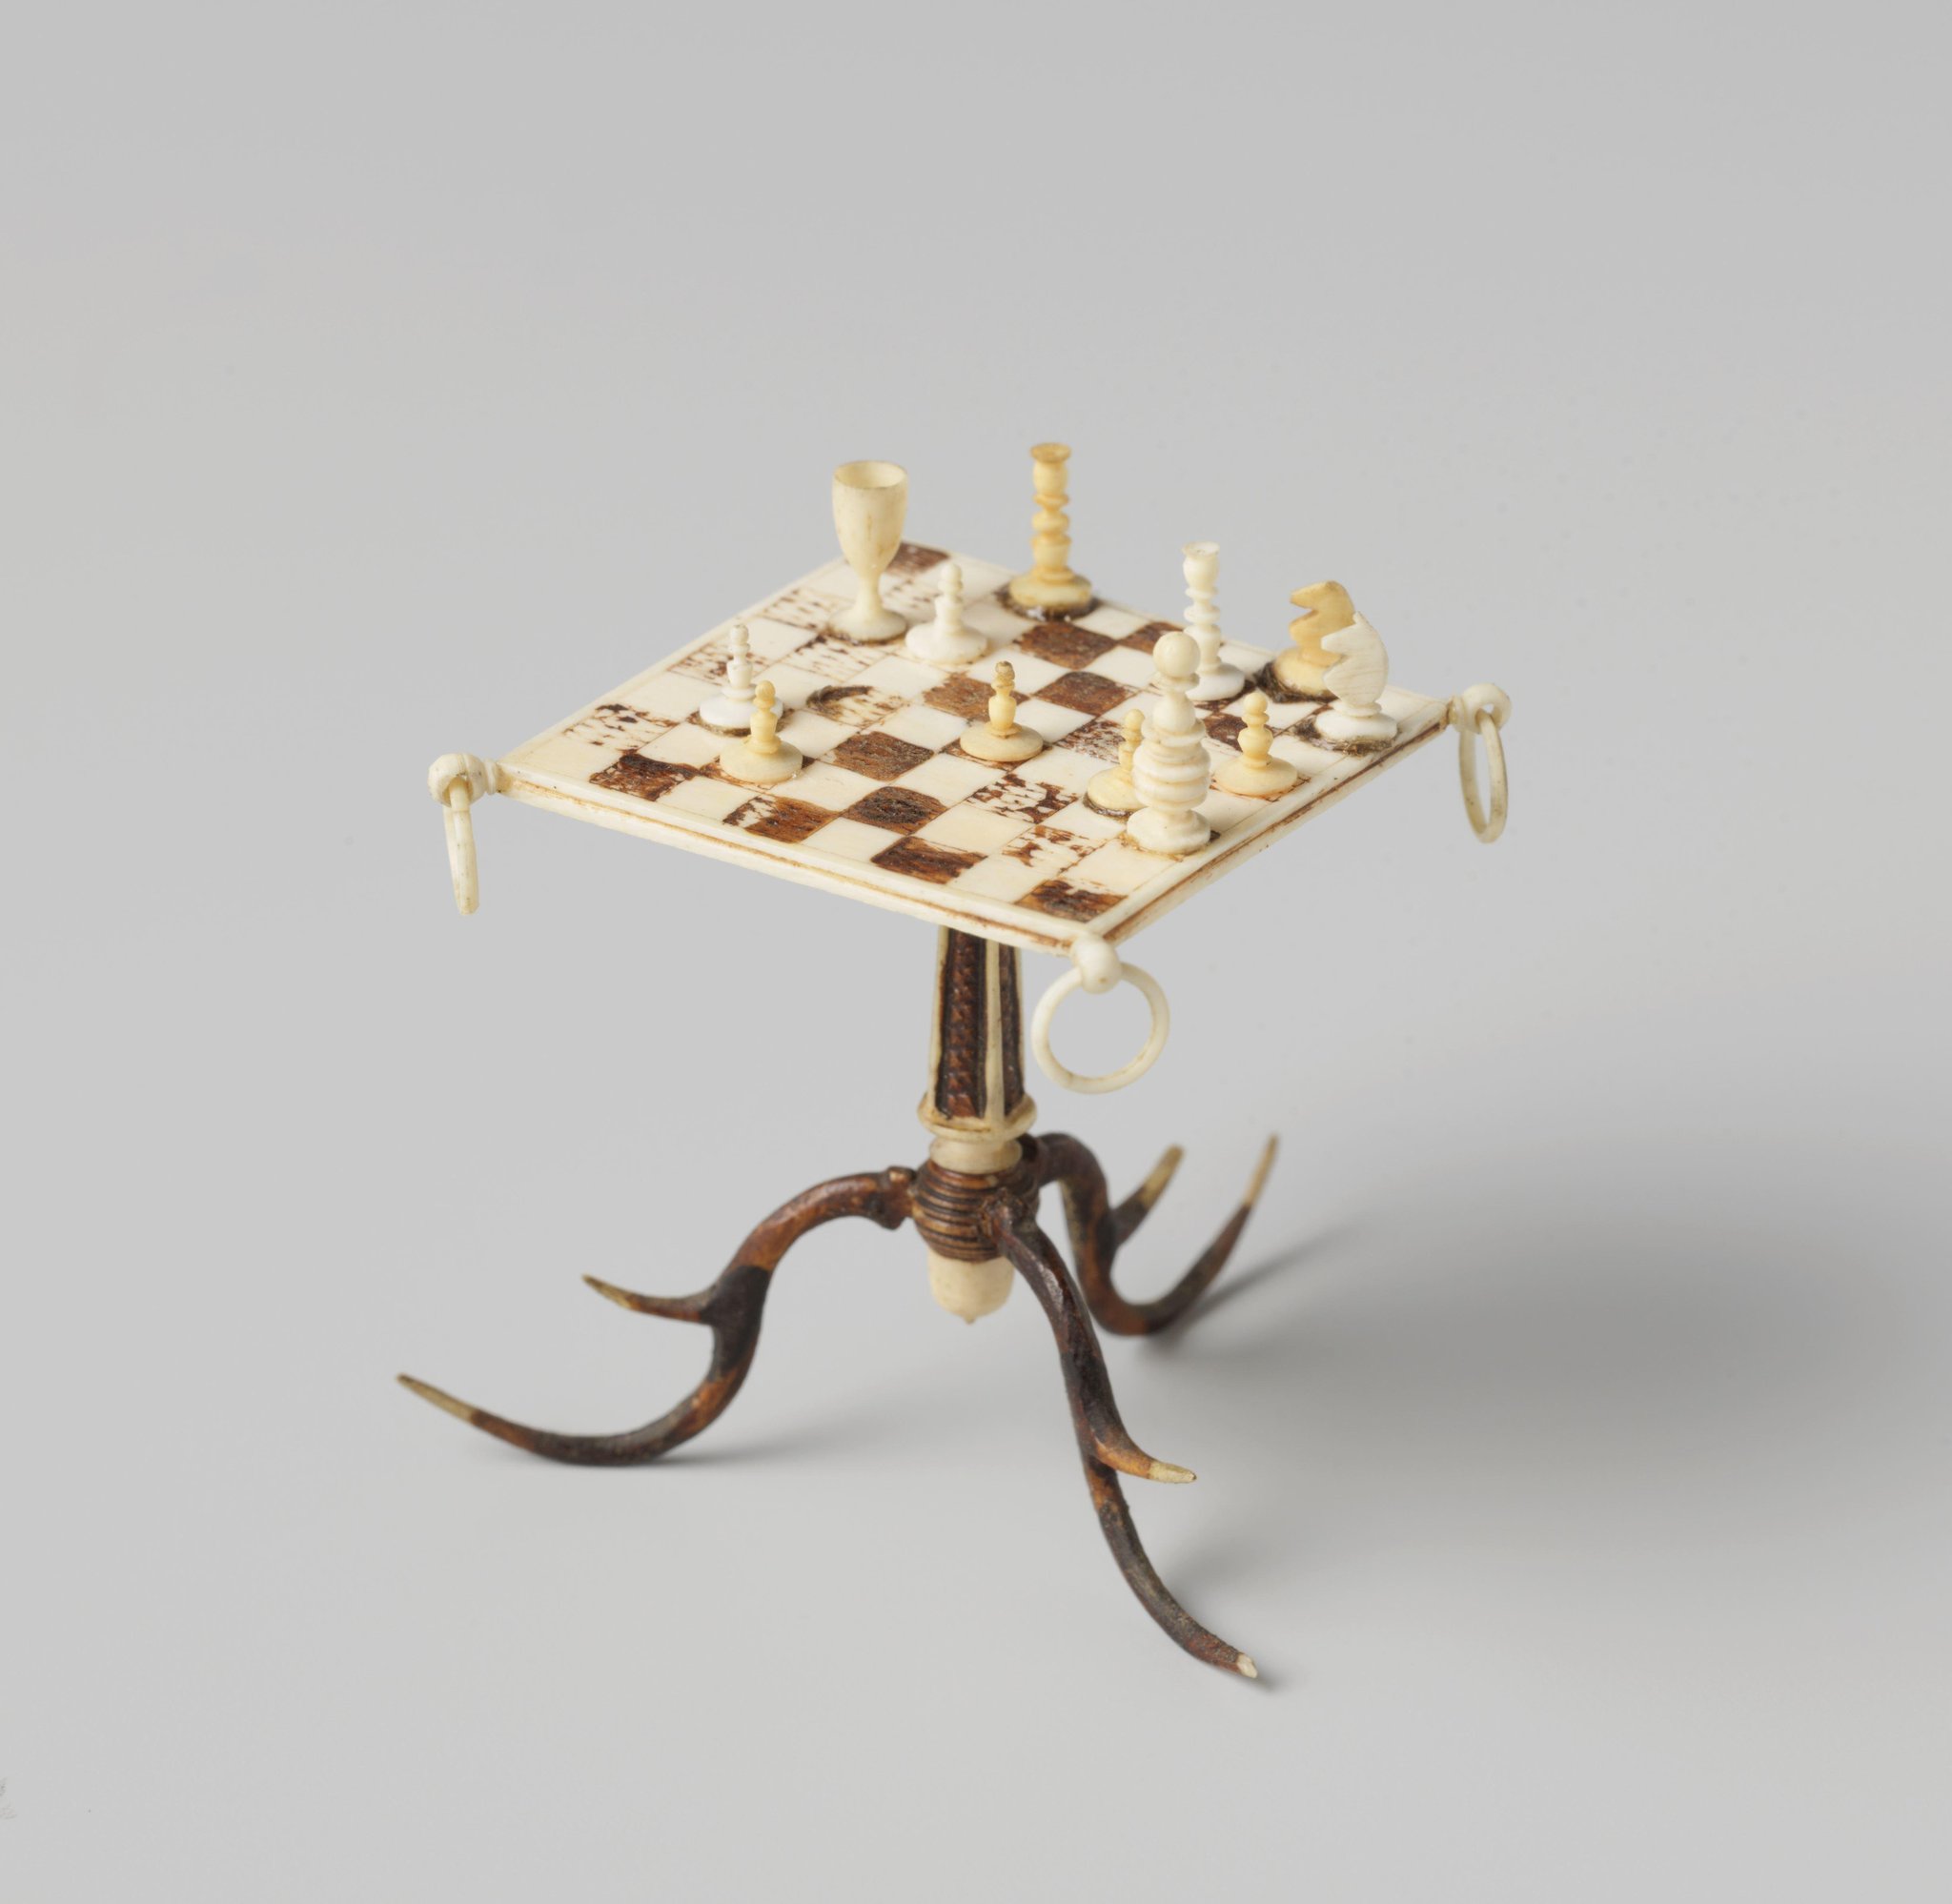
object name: chess set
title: Schaaktafel op een stam op drie s-vormige poten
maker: Anonymous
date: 1825-1874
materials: bone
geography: germany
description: Schaaktafel van been, het rechthoekig blad rust op een stam op drie s-vormige poten. Aan de vier hoeken van het bord zijn ringen bevestigd. Op het bord staan schaakstukken.